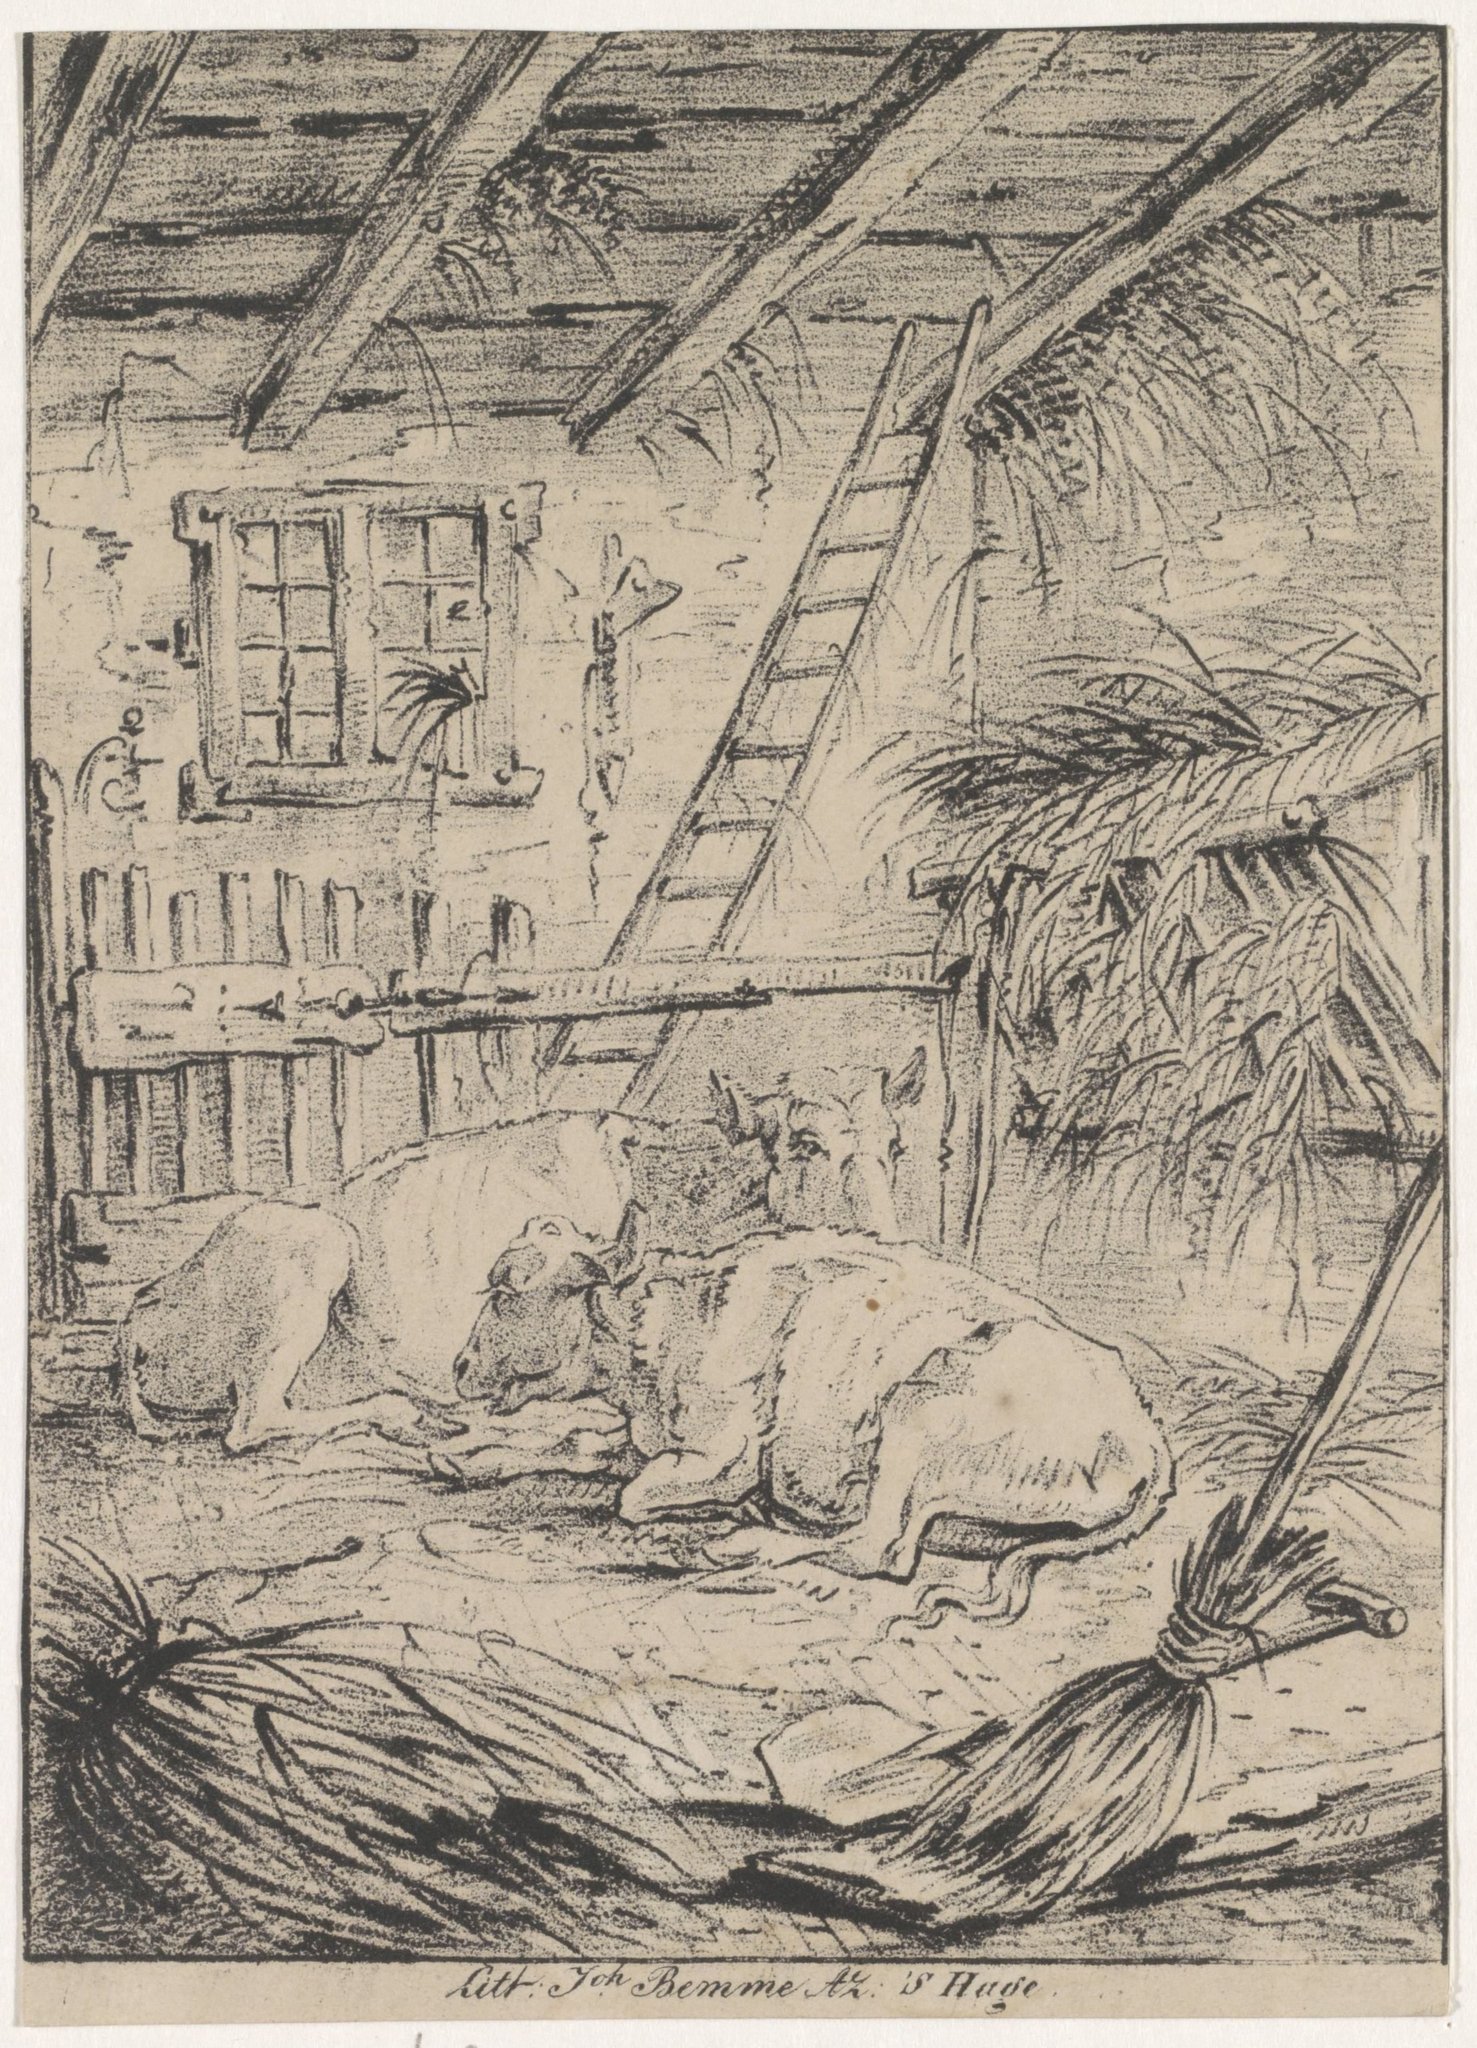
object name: print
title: Stal met koeien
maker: joannes bemme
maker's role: print maker, printer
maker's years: 1775-1841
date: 1831-1841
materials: paper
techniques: lithograph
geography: the hague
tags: cow, ladder, stall, stable, (household) utensils and implements (with name)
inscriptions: collector's mark: Lugt 2228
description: Op de grond liggen twee koeien. Achter hen staat een ladder, rechts van hen zit stro in een ruif en voorin staat een bezem.